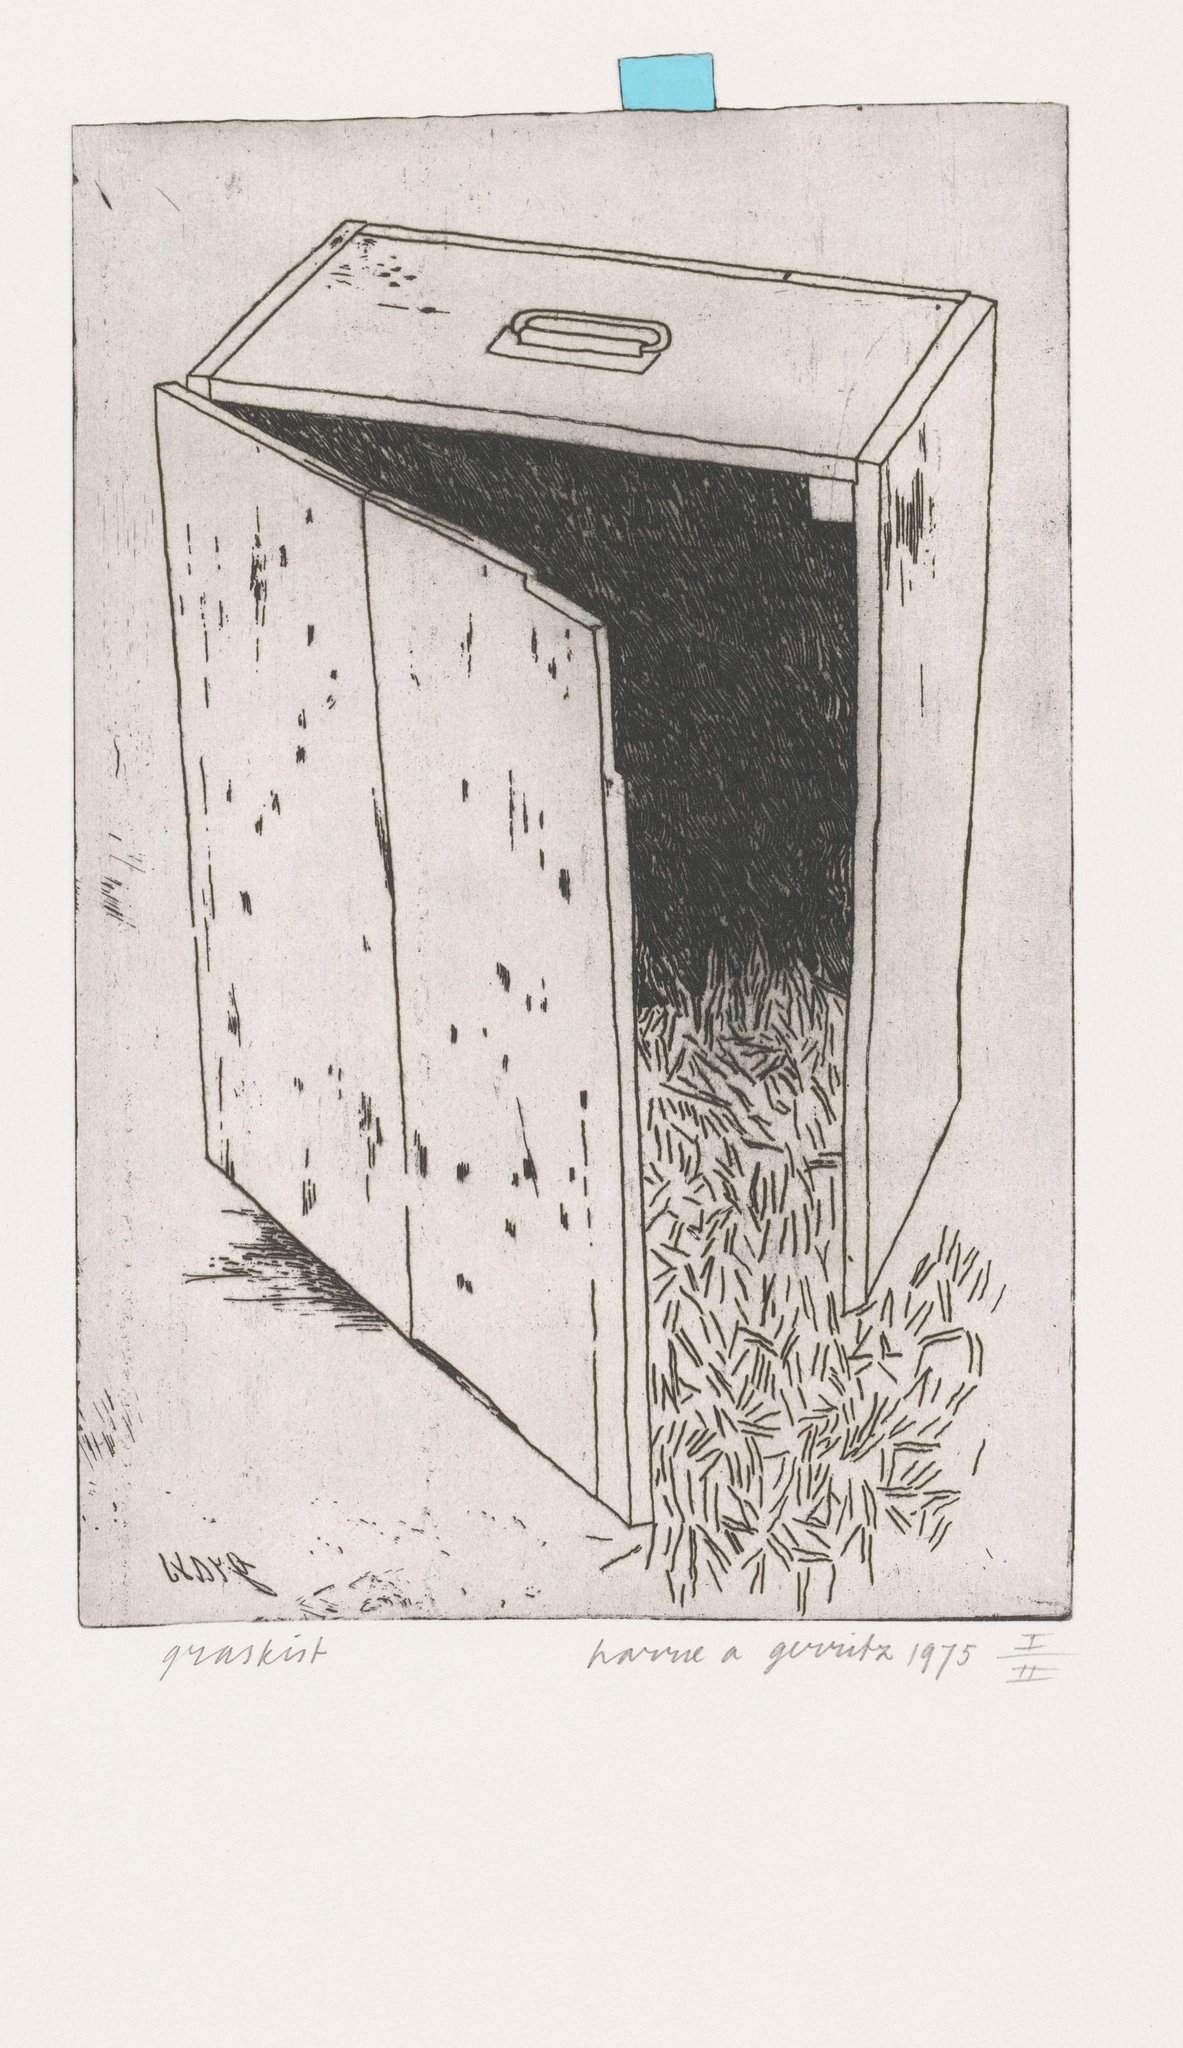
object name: print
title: Graskist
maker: harrie a. gerritz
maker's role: draughtsman, painter, print maker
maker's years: 1940-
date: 1975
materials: paper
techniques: etching, hand coloring, intaglio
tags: meadow, pasture, chest, coffer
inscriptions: inscription: ‘PC’, collector's mark: Lugt 2228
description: Staande kist met half open deksel waardoor de inhoud met gras naar buiten komt, rechtsboven een blauw vlakje.